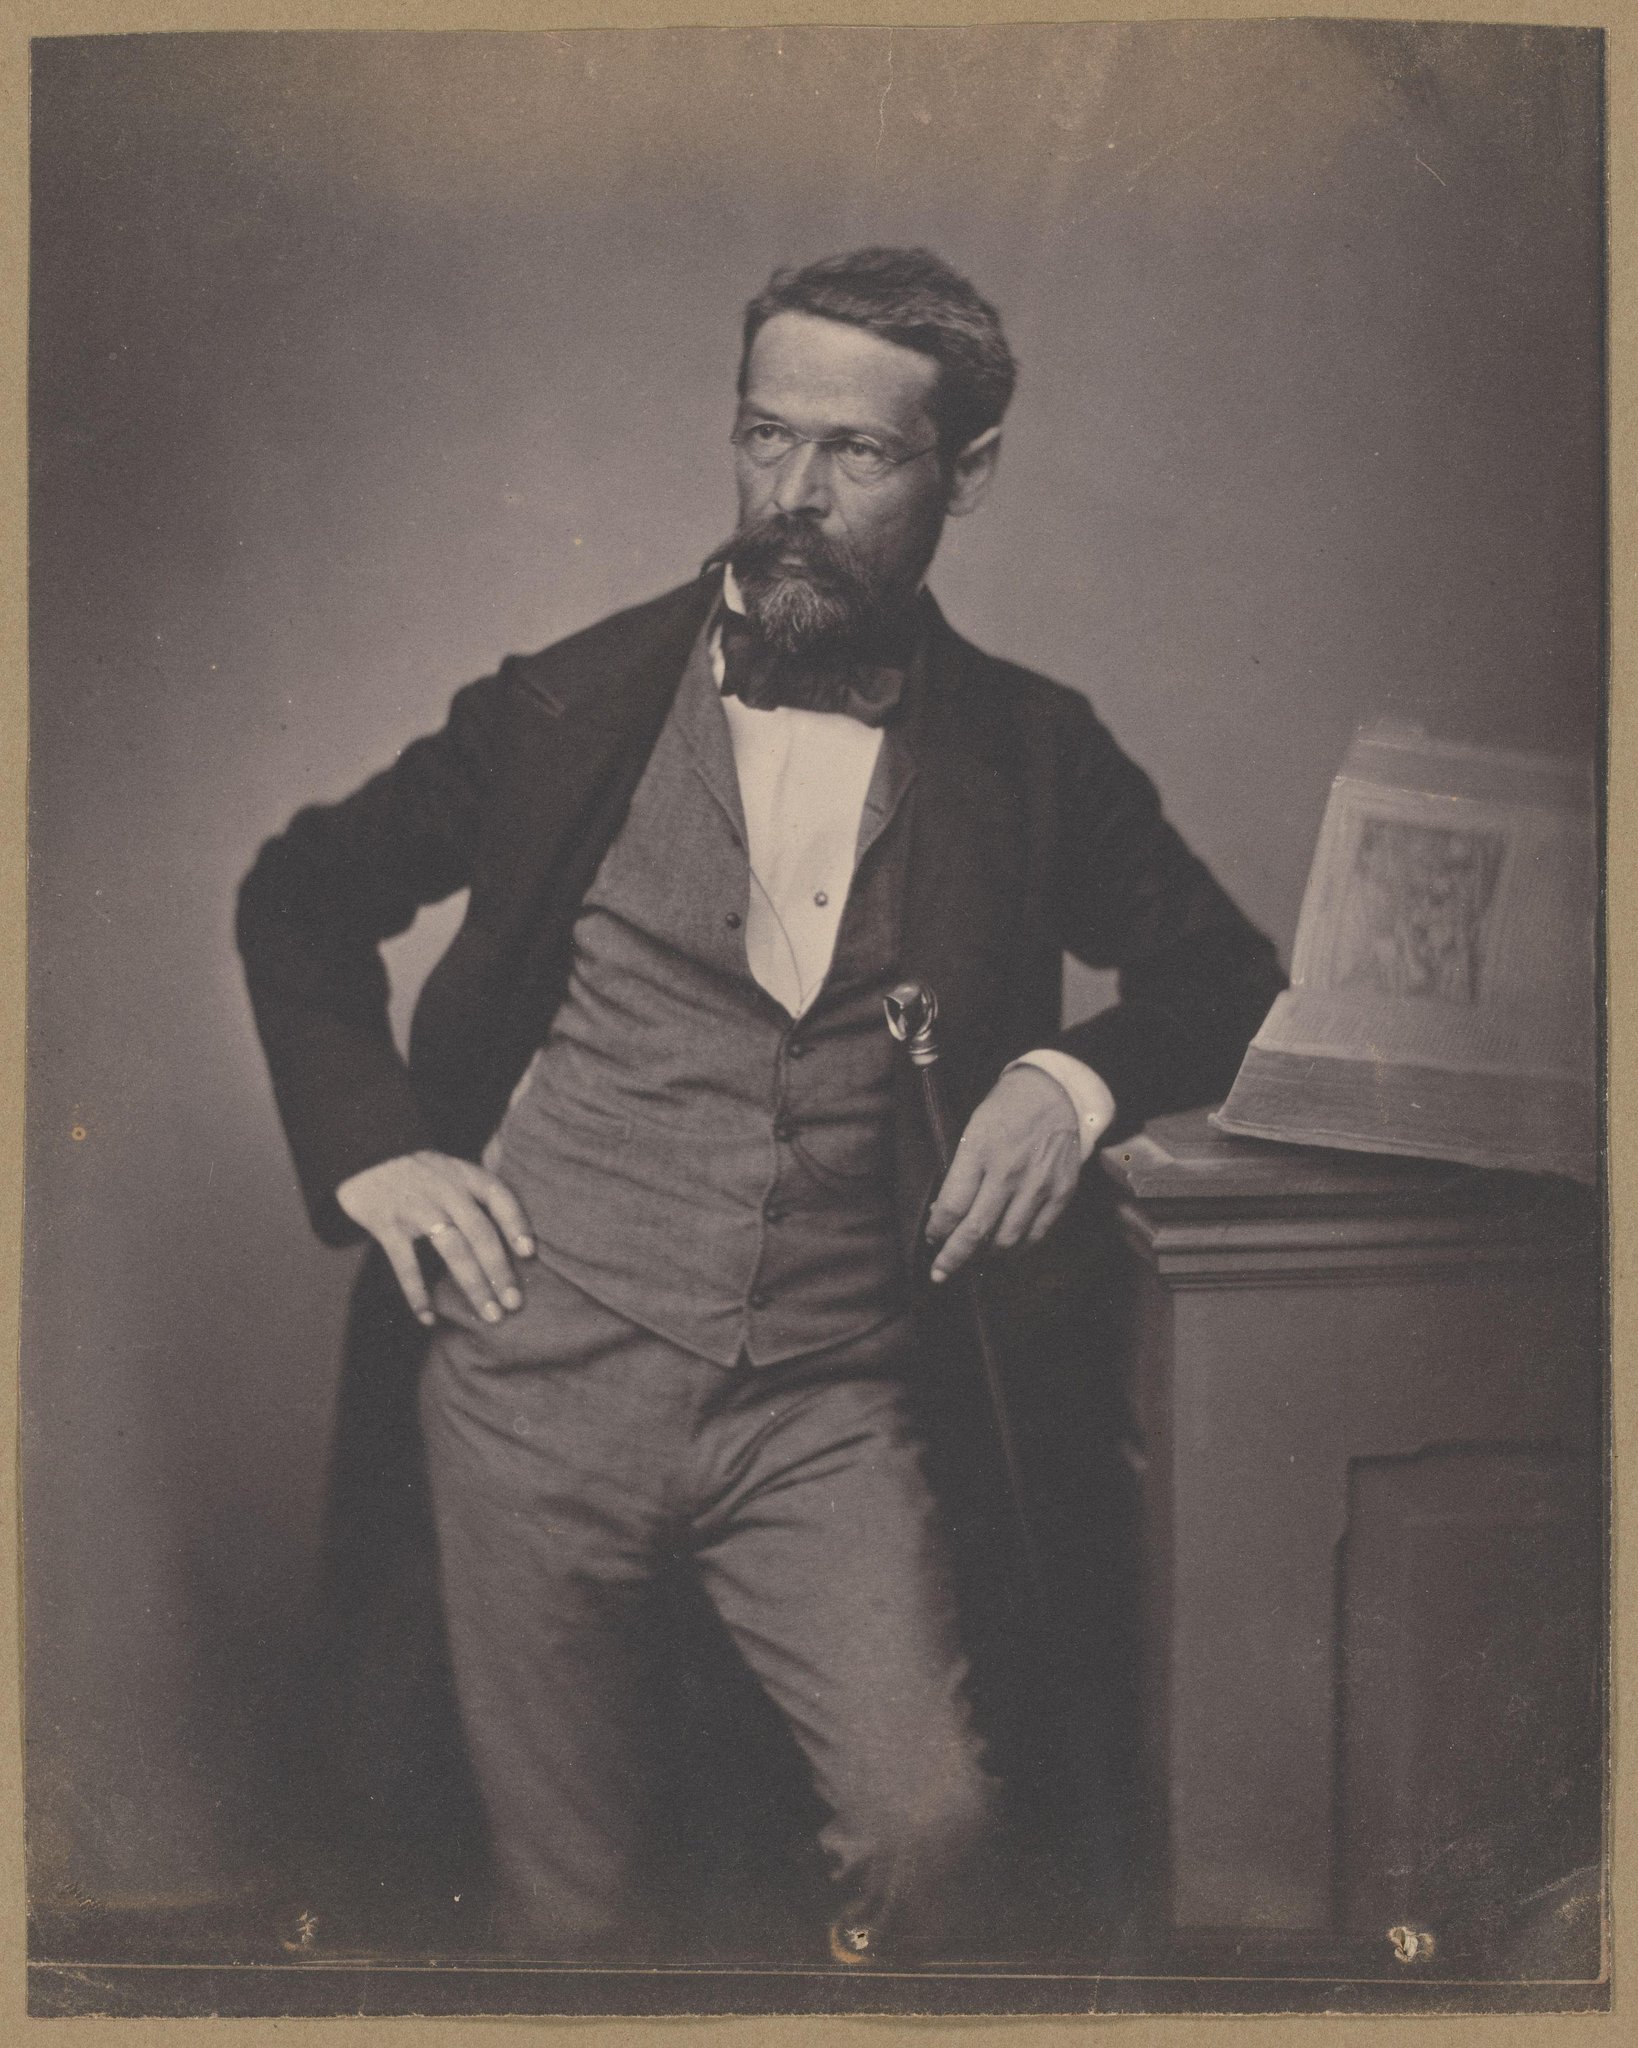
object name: photograph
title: Portret van een onbekende man met bril en baard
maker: franz seraph hanfstaengl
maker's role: painter, print maker, printer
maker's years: 1804-1877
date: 1855-1860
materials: paper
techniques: salted paper print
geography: germany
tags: anonymous historical person portrayed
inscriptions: inscription: ‘[Ingammik[onz]’